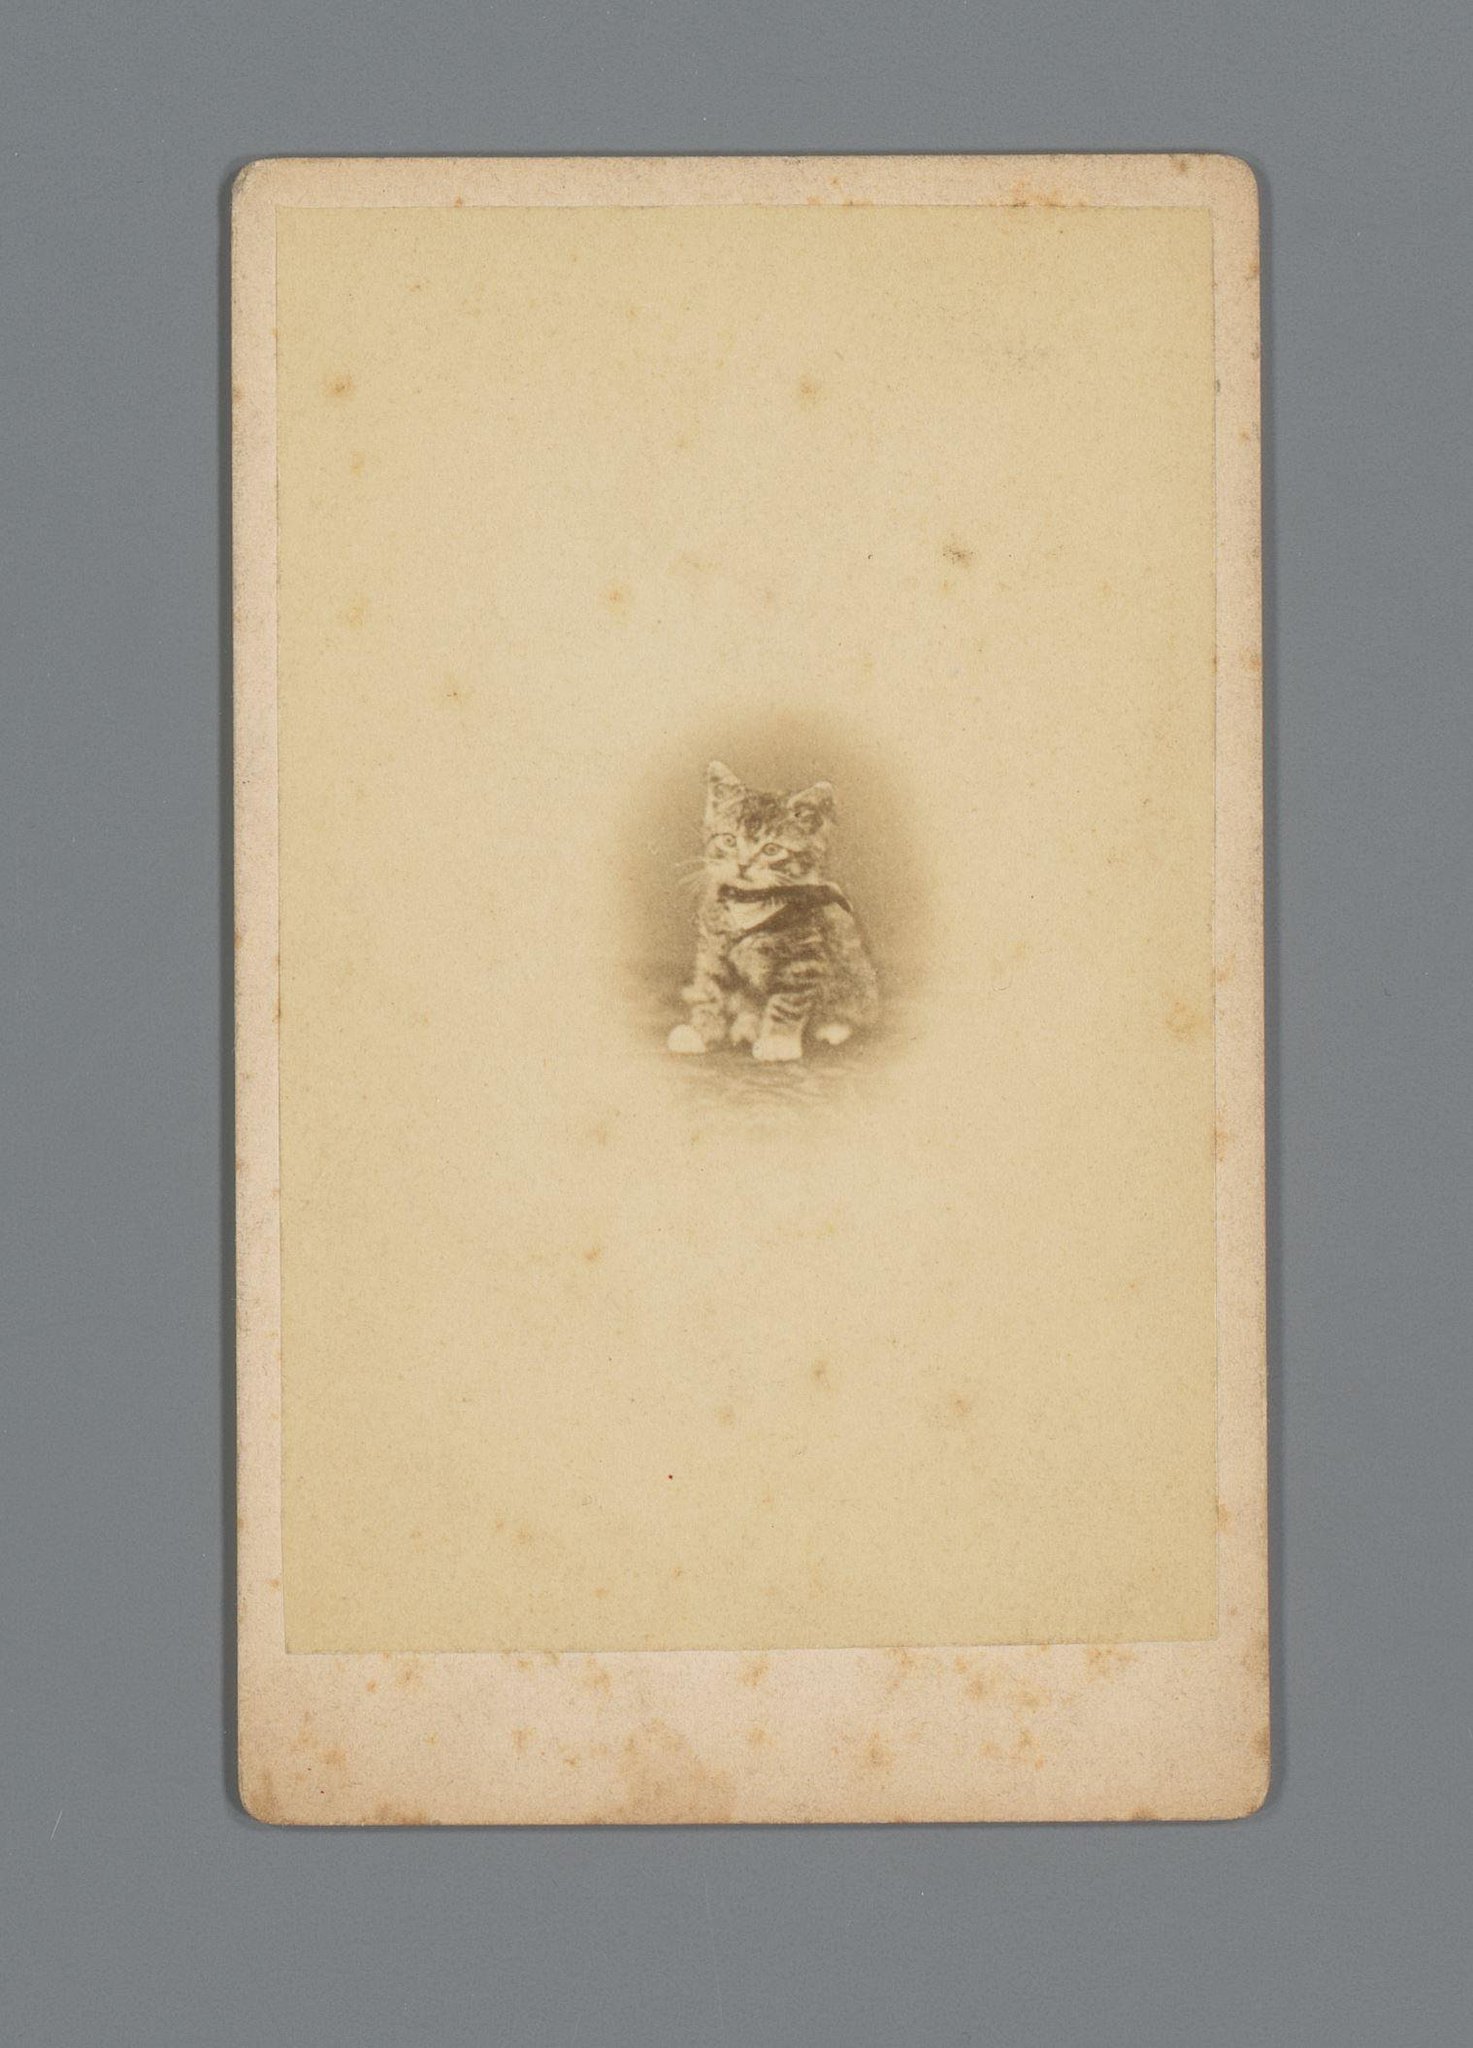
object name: carte de visite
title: Miniatuurportret van een kitten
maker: Anonymous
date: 1854-1885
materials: cardboard, paper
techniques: albumen print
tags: cat